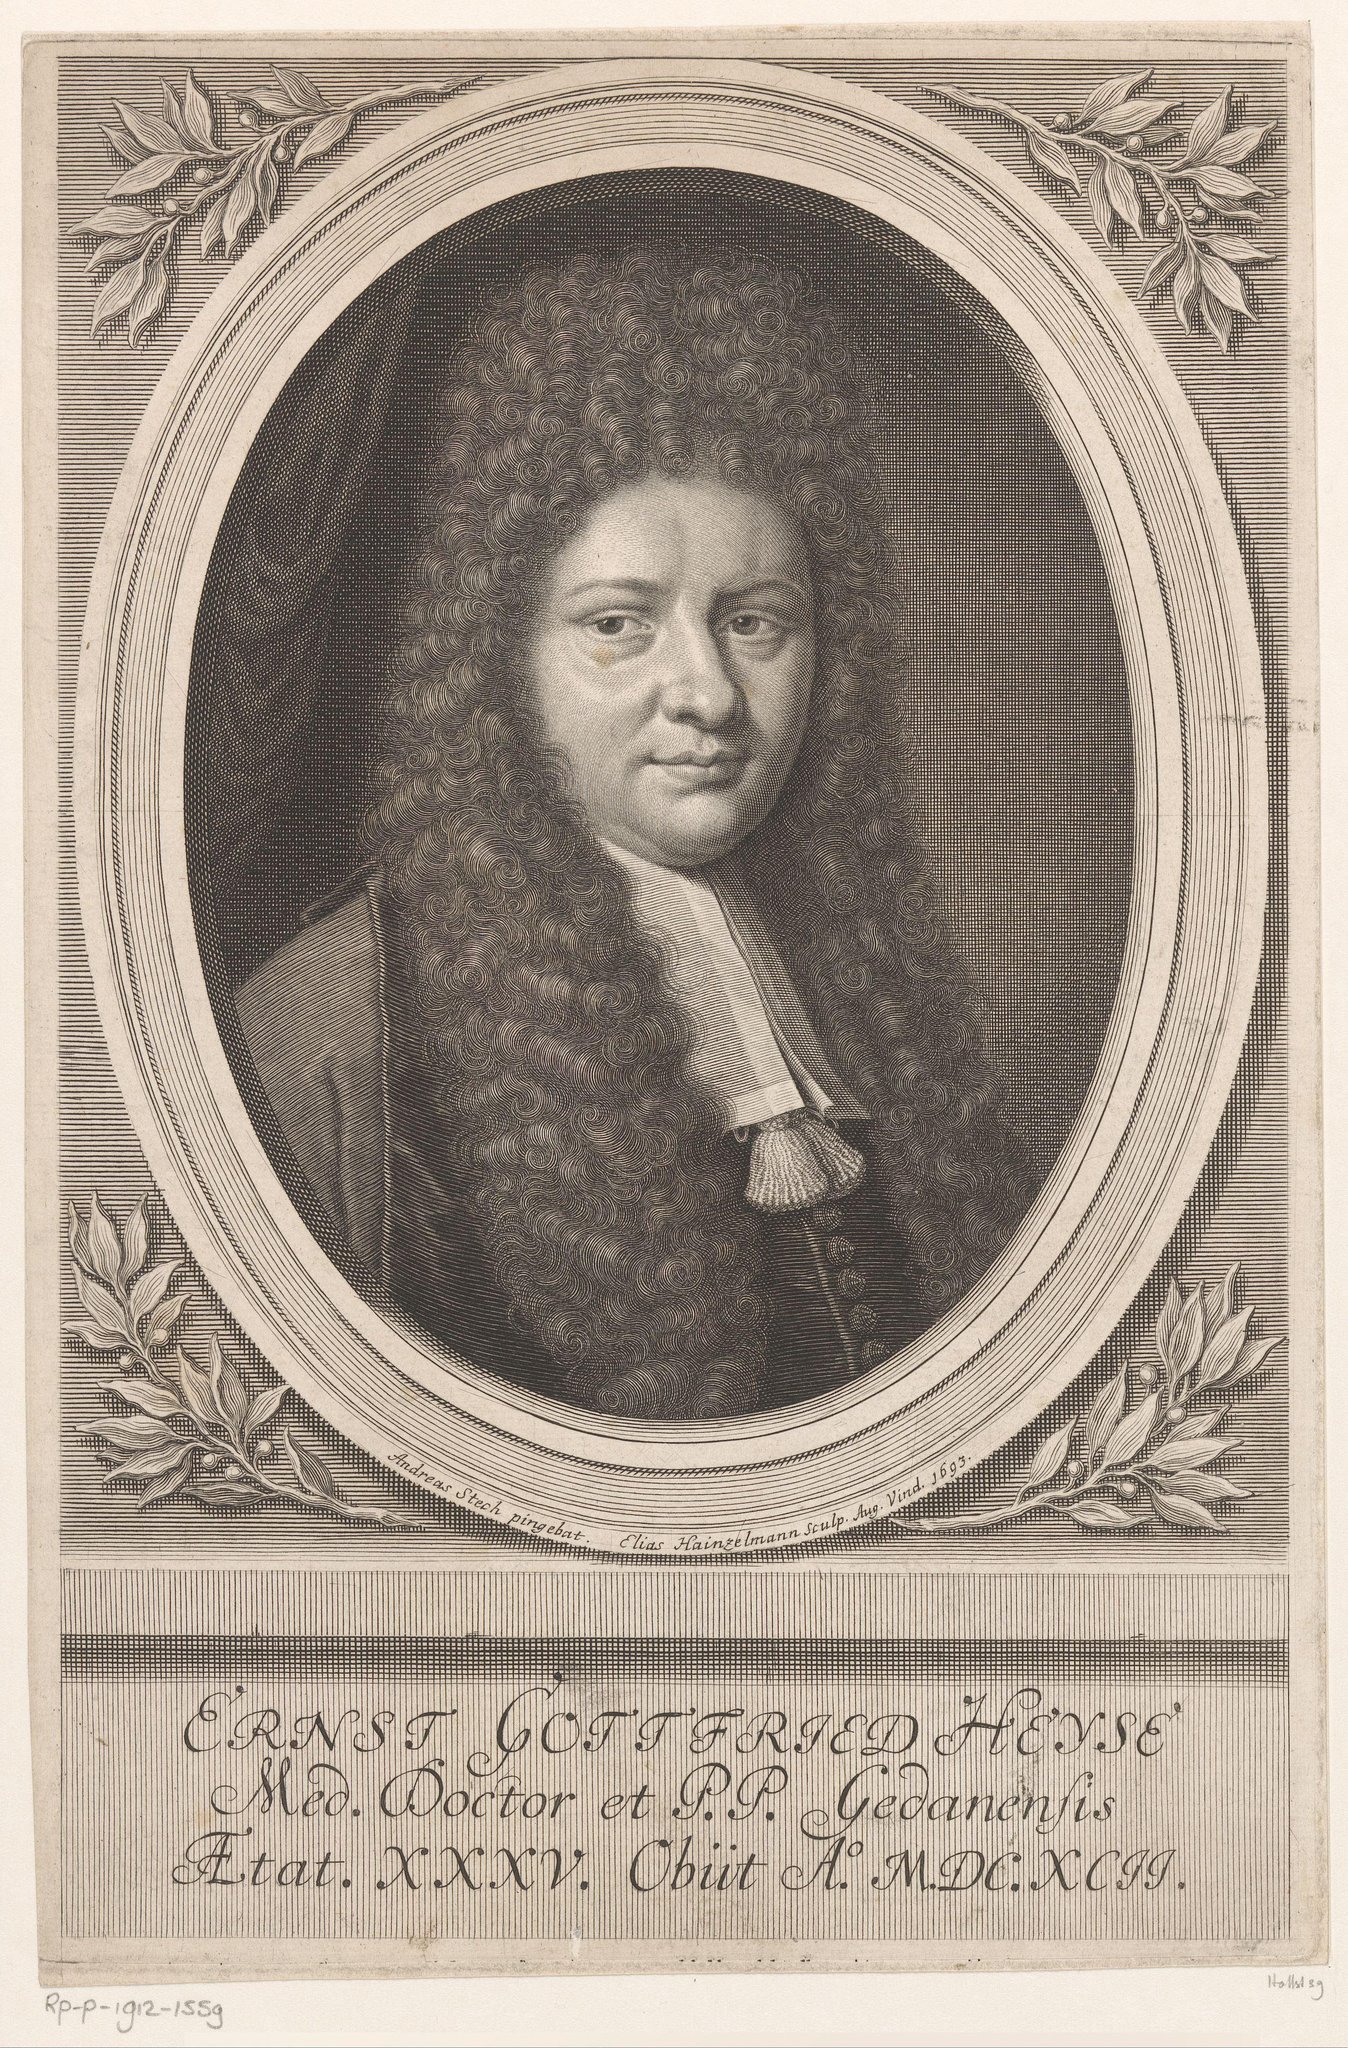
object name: print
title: Portret van Ernst Gottfried Heyse op 35-jarige leeftijd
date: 1693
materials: paper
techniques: engraving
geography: augsburg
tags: trees: laurel (branch, stick), historical persons, physician, doctor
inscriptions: collector's mark: Lugt 2228